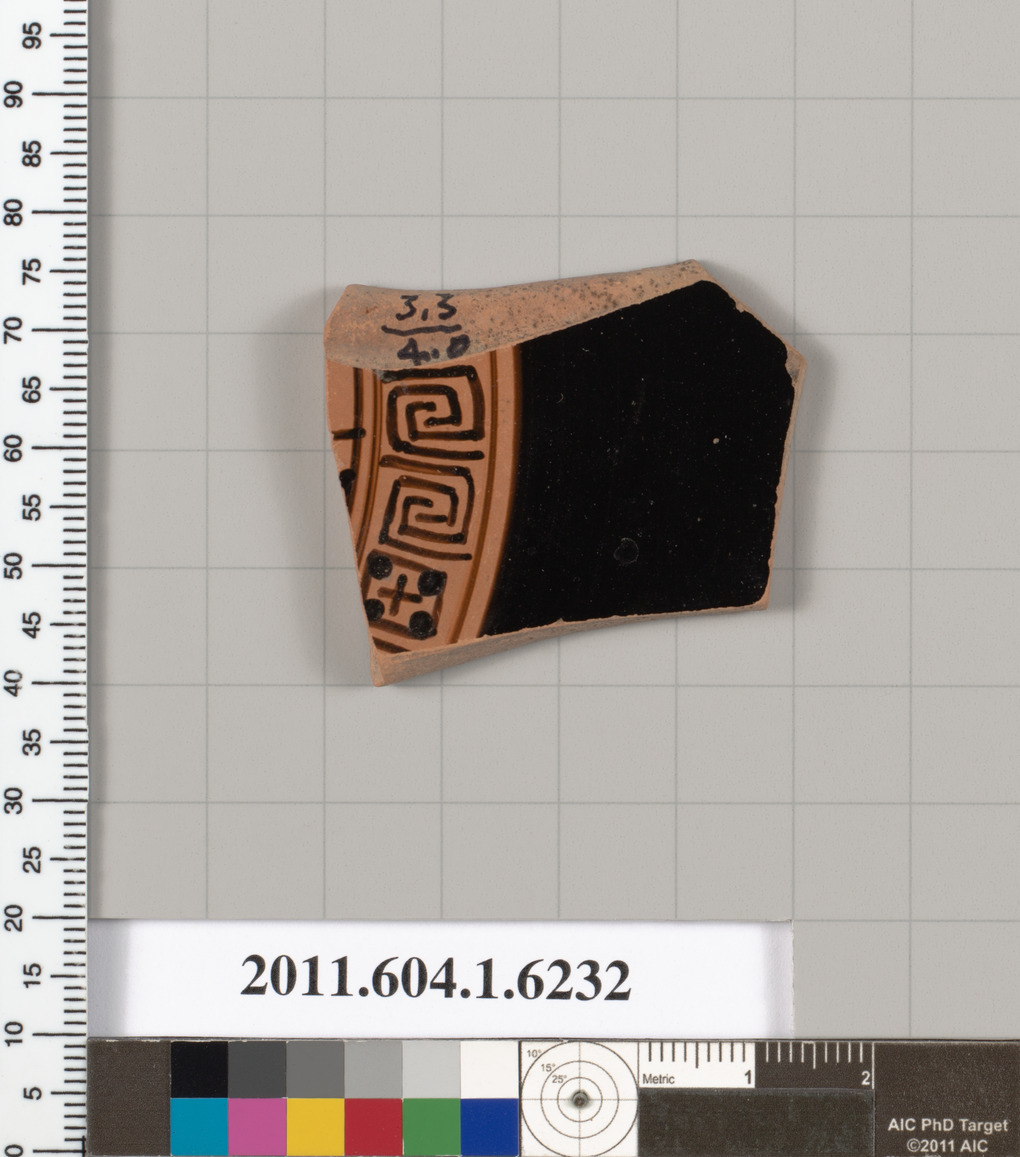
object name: kylix fragment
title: Terracotta fragment of a kylix (drinking cup)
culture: greek, attic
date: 500-480 BCE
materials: terracotta